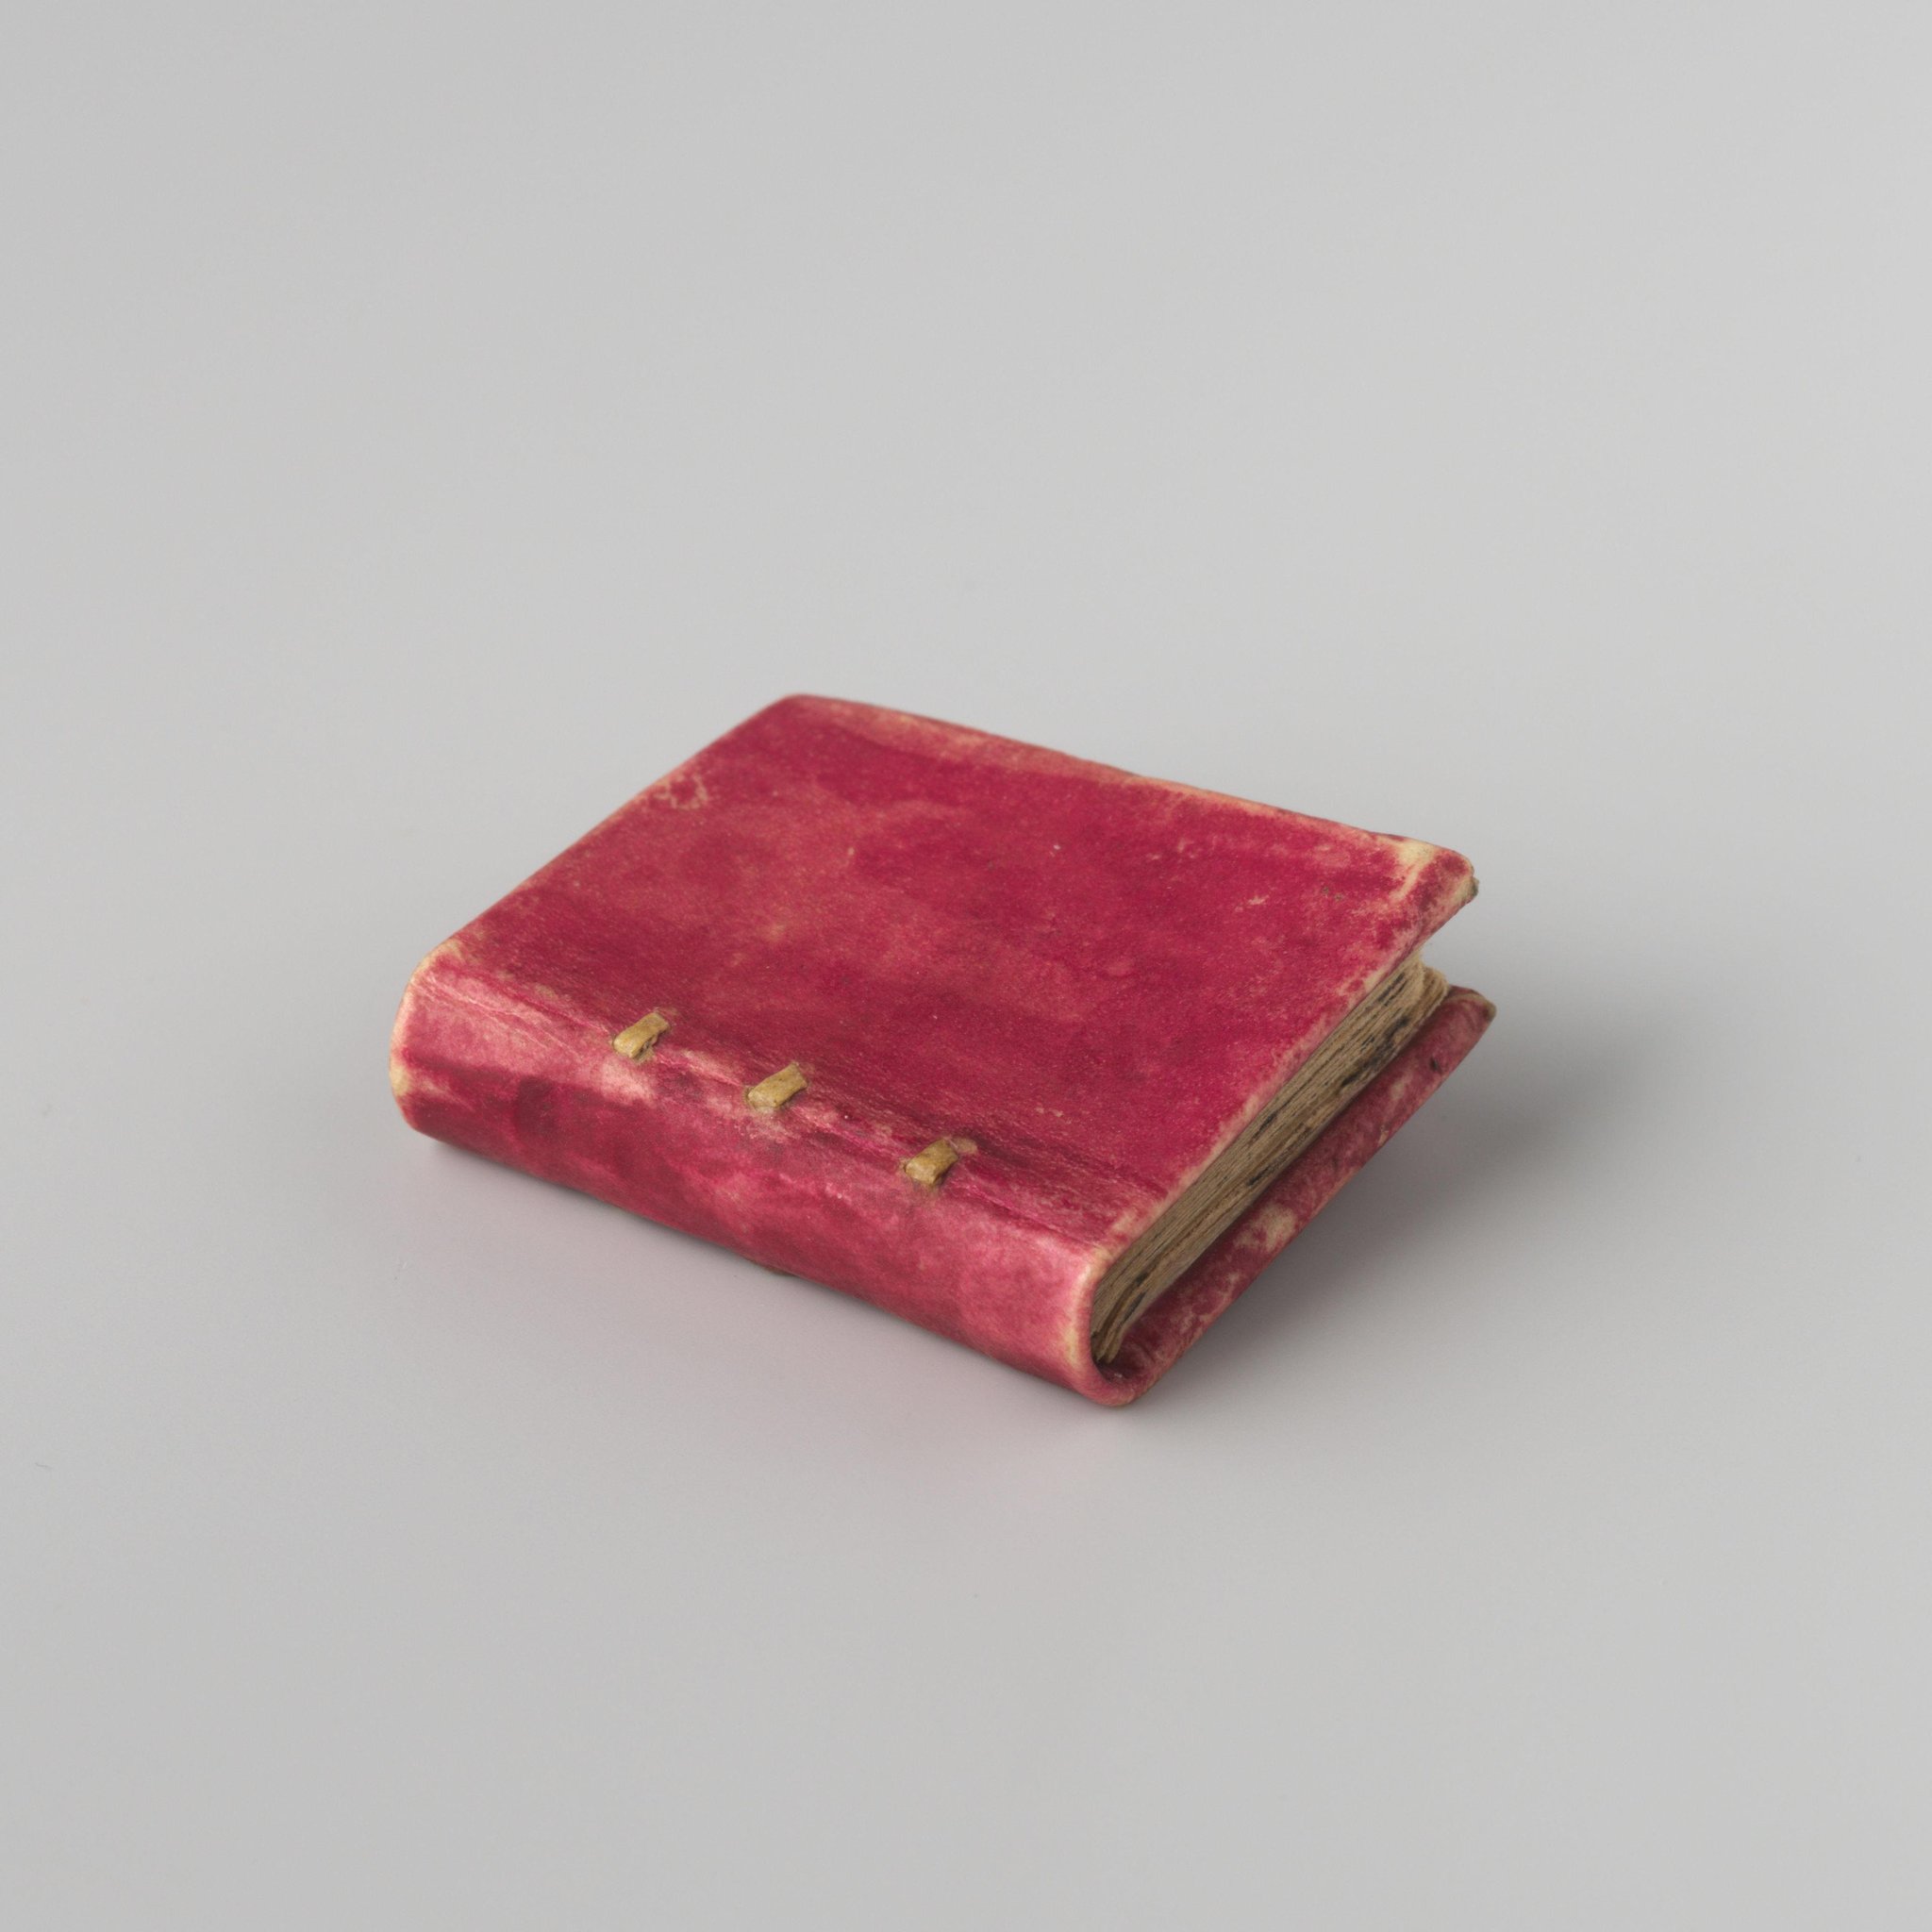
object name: album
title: Wapenboek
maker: Anonymous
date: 1678-1683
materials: paper, parchment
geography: amsterdam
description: Boek, gebonden in hardroze gekleurd perkament (splitsel binding), snede gedeeltelijk versierd; boek met 9 katernen, eerste en laatste blanco, van 4 bladen, waarbij de bladzijden zijn gevormd door uitgeknipte, en deels aan een plakstrook van het voorafgaande blad aangehechte familiewapens, recto bedrukt, geknipt uit wapenstroken, een z.g. 'Vermeerdering', met geslachtswapens en grote wapens van Stadhouder Willem III, Maria Stuart, Cornelis Tromp en Engel, Baron de Ruyter, gedrukt tussen 1678 en 1683.